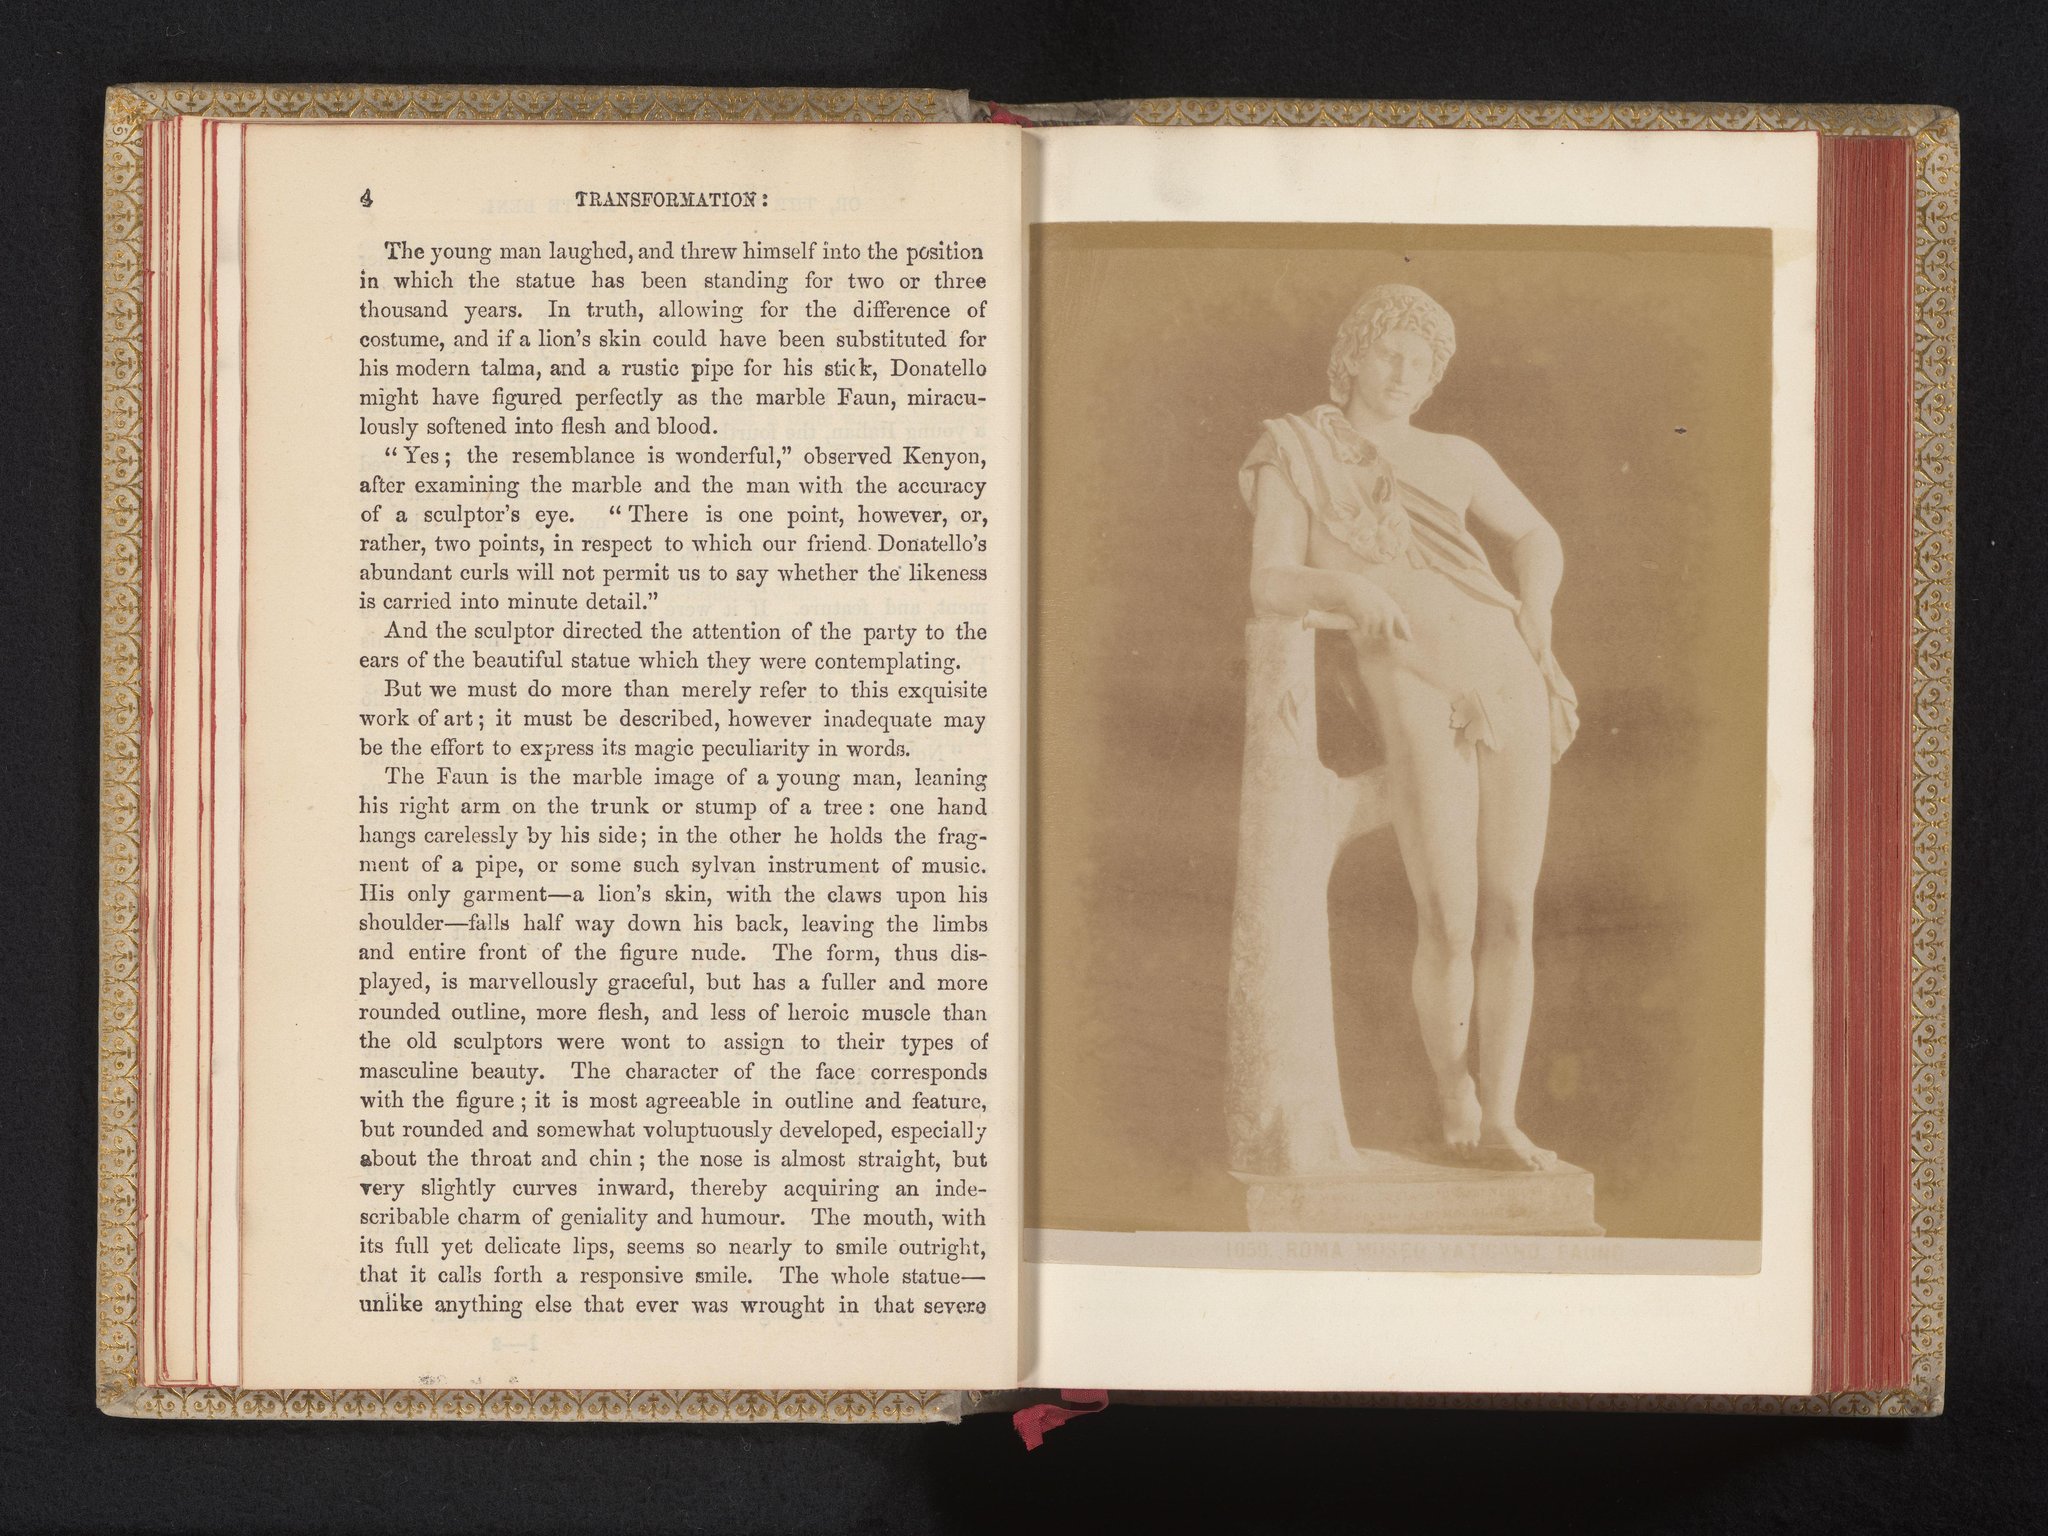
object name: photograph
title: Rustende satyr door Praxiteles in de Vaticaanse Musea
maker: Anonymous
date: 1883-1888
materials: paper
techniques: albumen print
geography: vatican museums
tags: sculpture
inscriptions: number: ‘1059.’